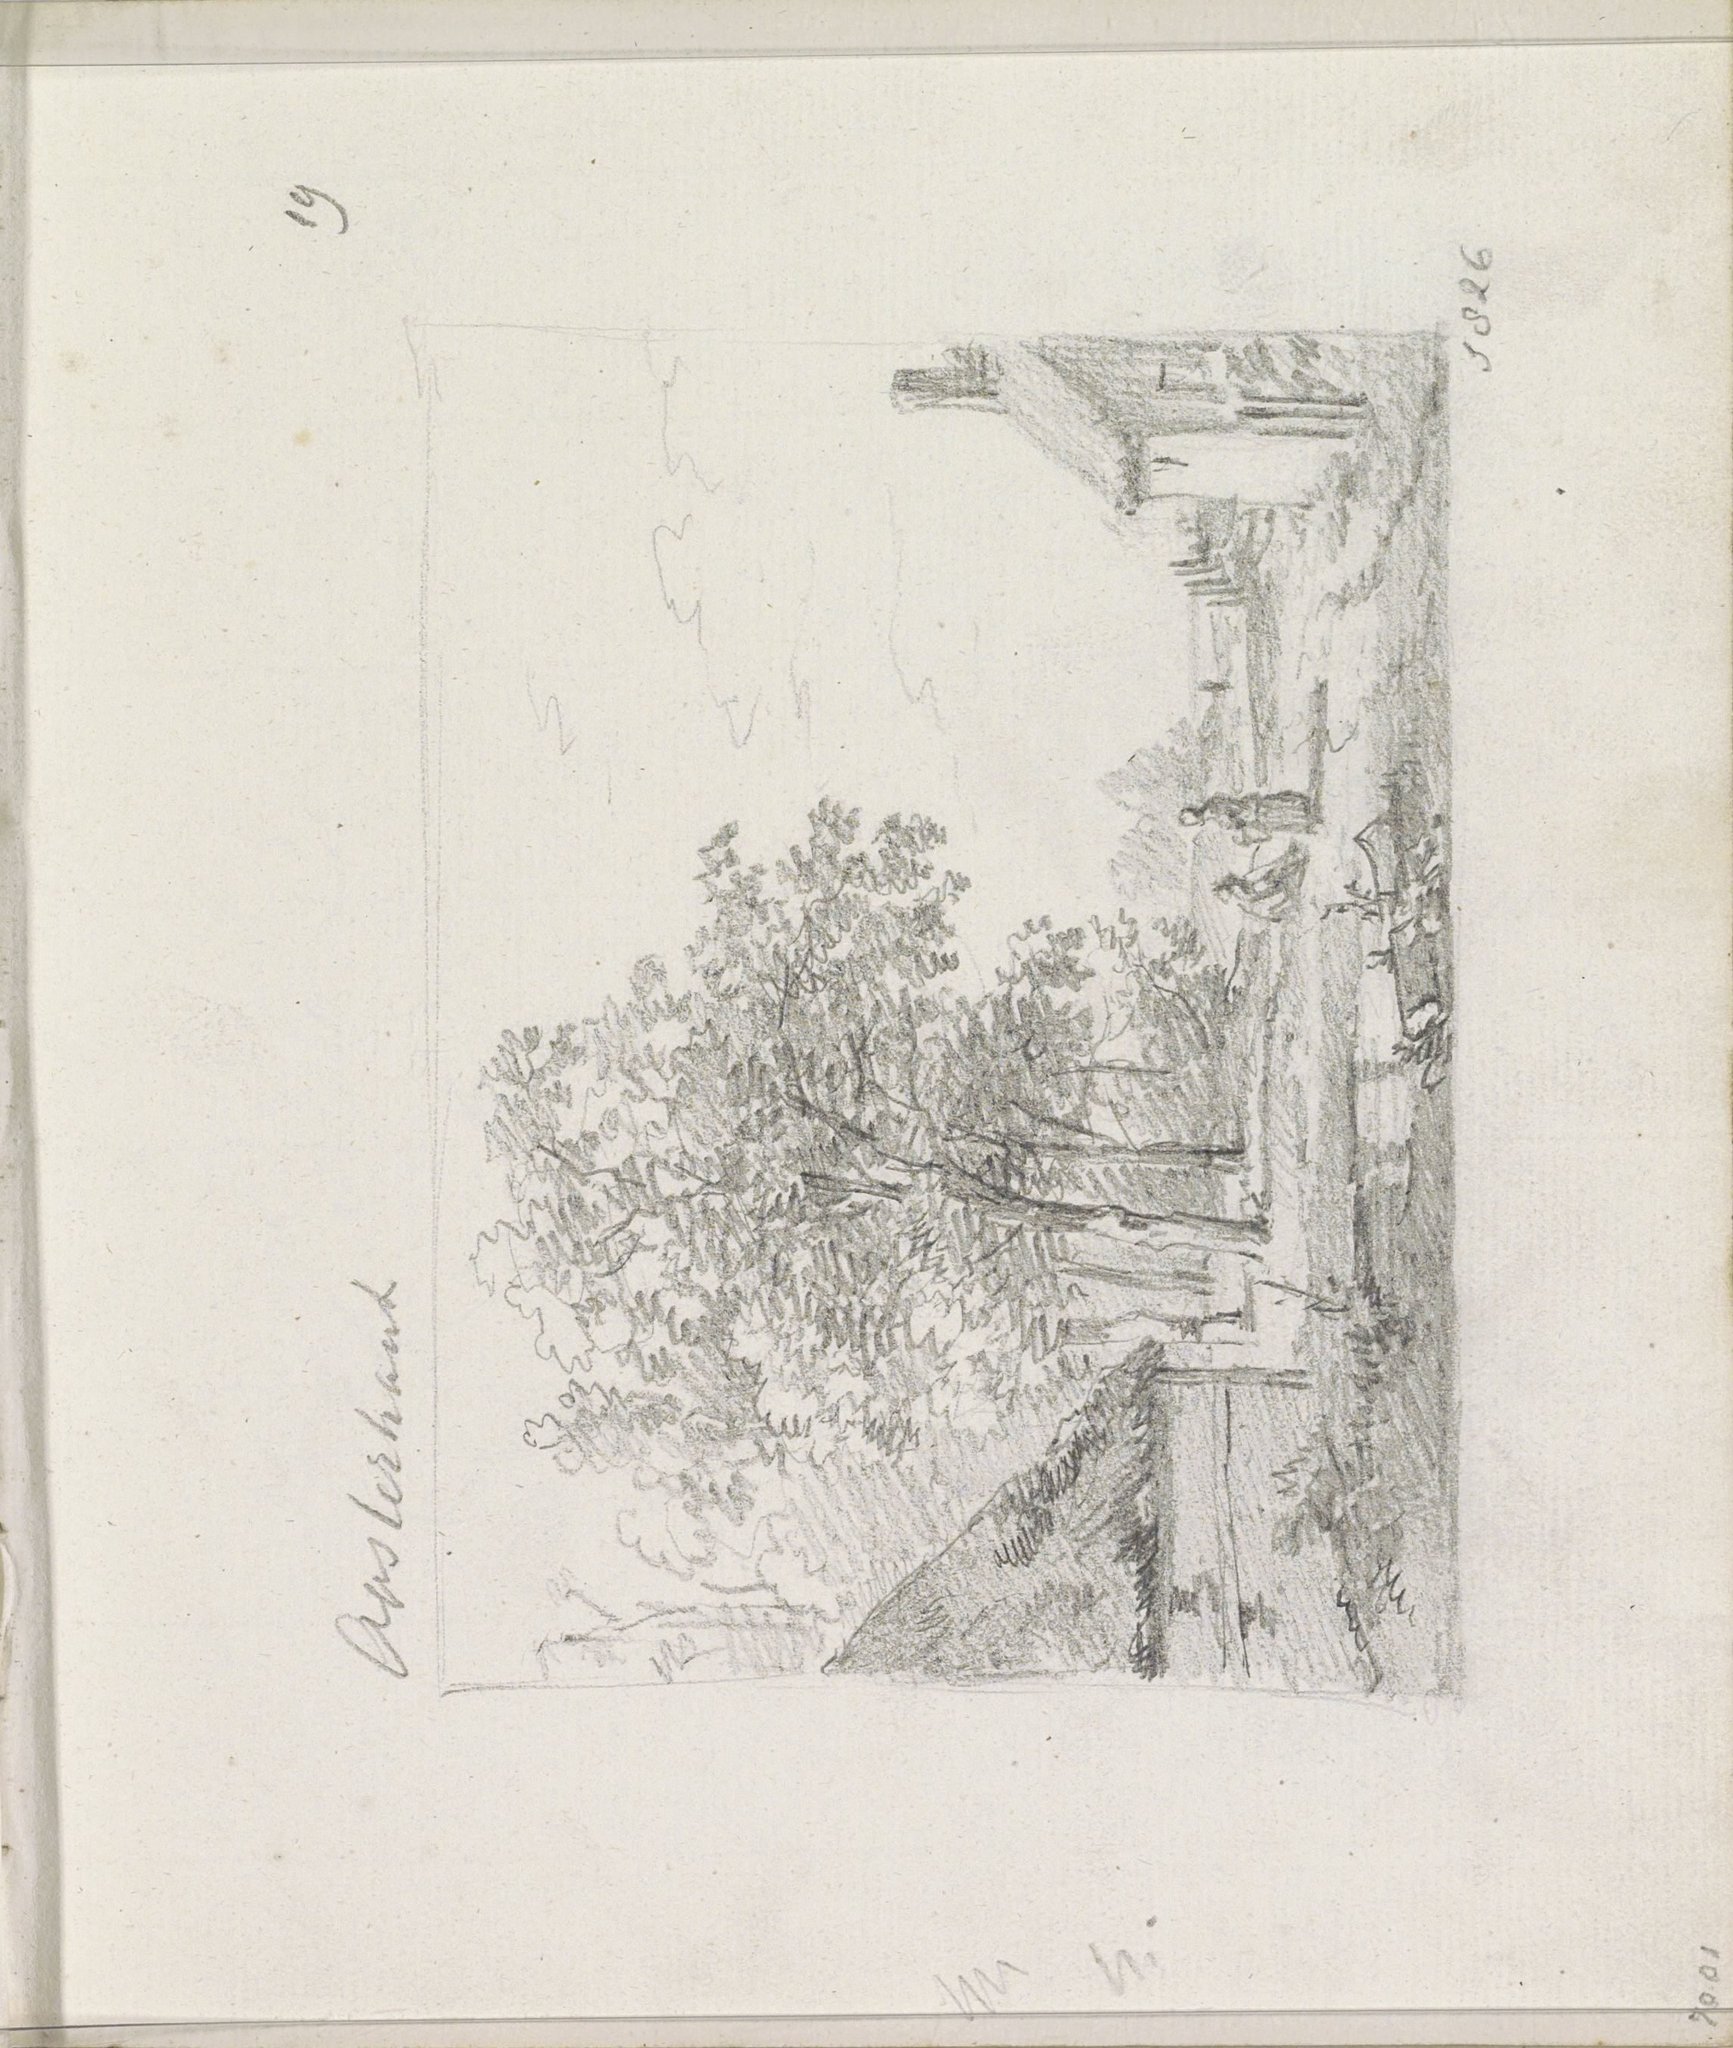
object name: sketchbook leaf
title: Landschap met twee figuren op een grasveld tussen twee huizen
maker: andreas schelfhout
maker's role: draughtsman, painter, print maker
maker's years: 1787-1870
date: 1826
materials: paper, pencil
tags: rural housing, e.g. country-house, villa, cottage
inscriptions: number: ‘19/ 7001’, date and inscription: ‘A[...]lerhant/ 1826’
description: Tussen de huizen ligt een plas en een boomstam. Blad 33 recto uit een schetsboek met 95 bladen.